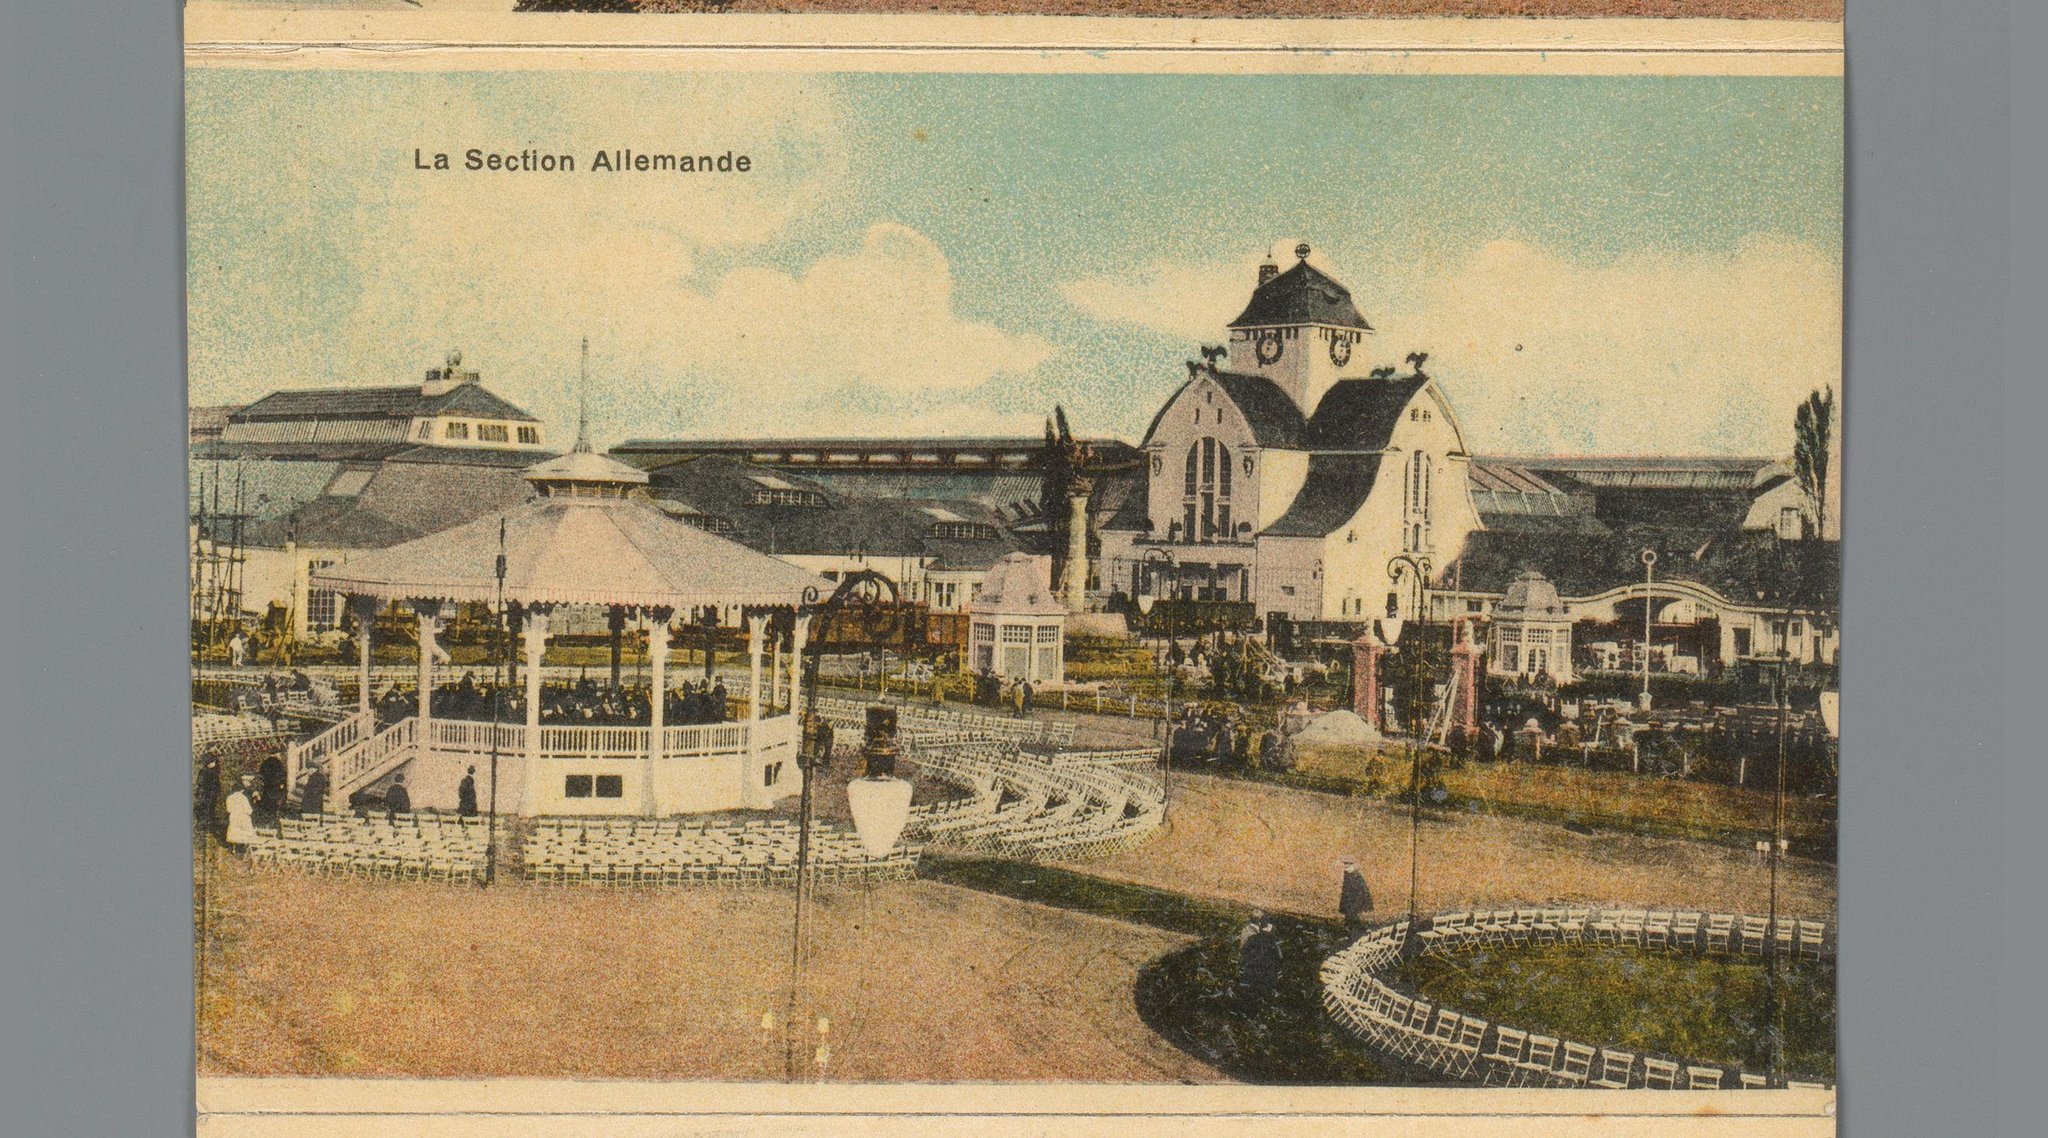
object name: photomechanical print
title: La Section Allemande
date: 1910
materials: cardboard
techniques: photograph, lithograph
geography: brussels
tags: world fair, world exhibition, bandstand, prospect of city, town panorama, silhouette of city, brussels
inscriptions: date